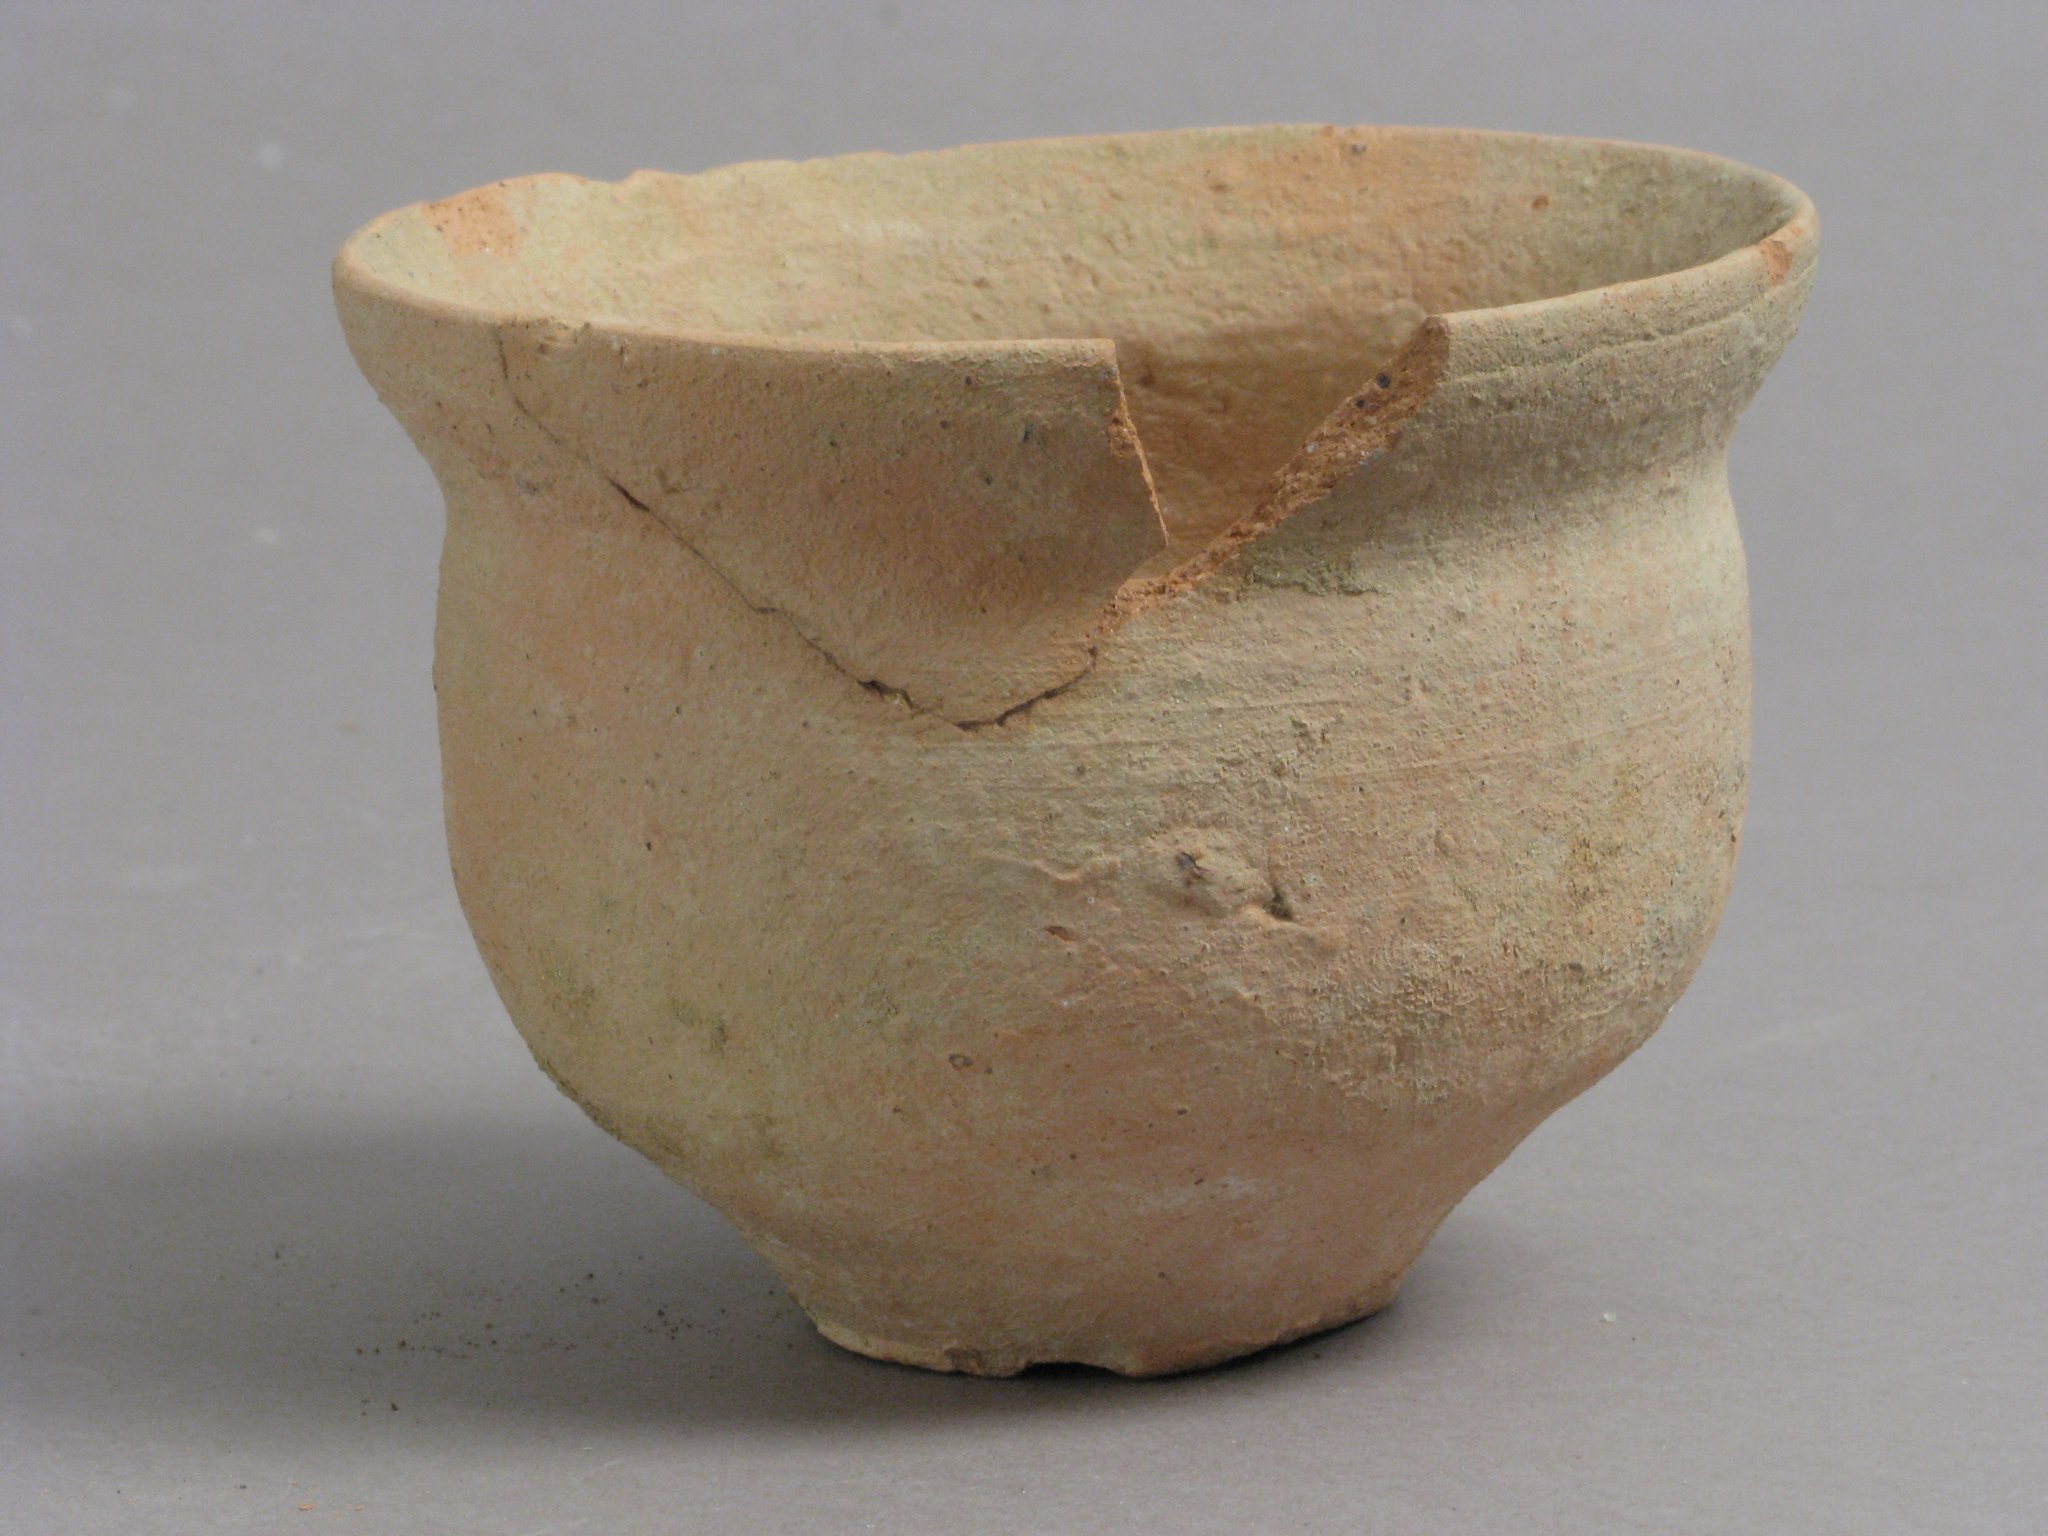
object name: bowl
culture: coptic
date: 301-700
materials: earthenware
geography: egypt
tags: bowls